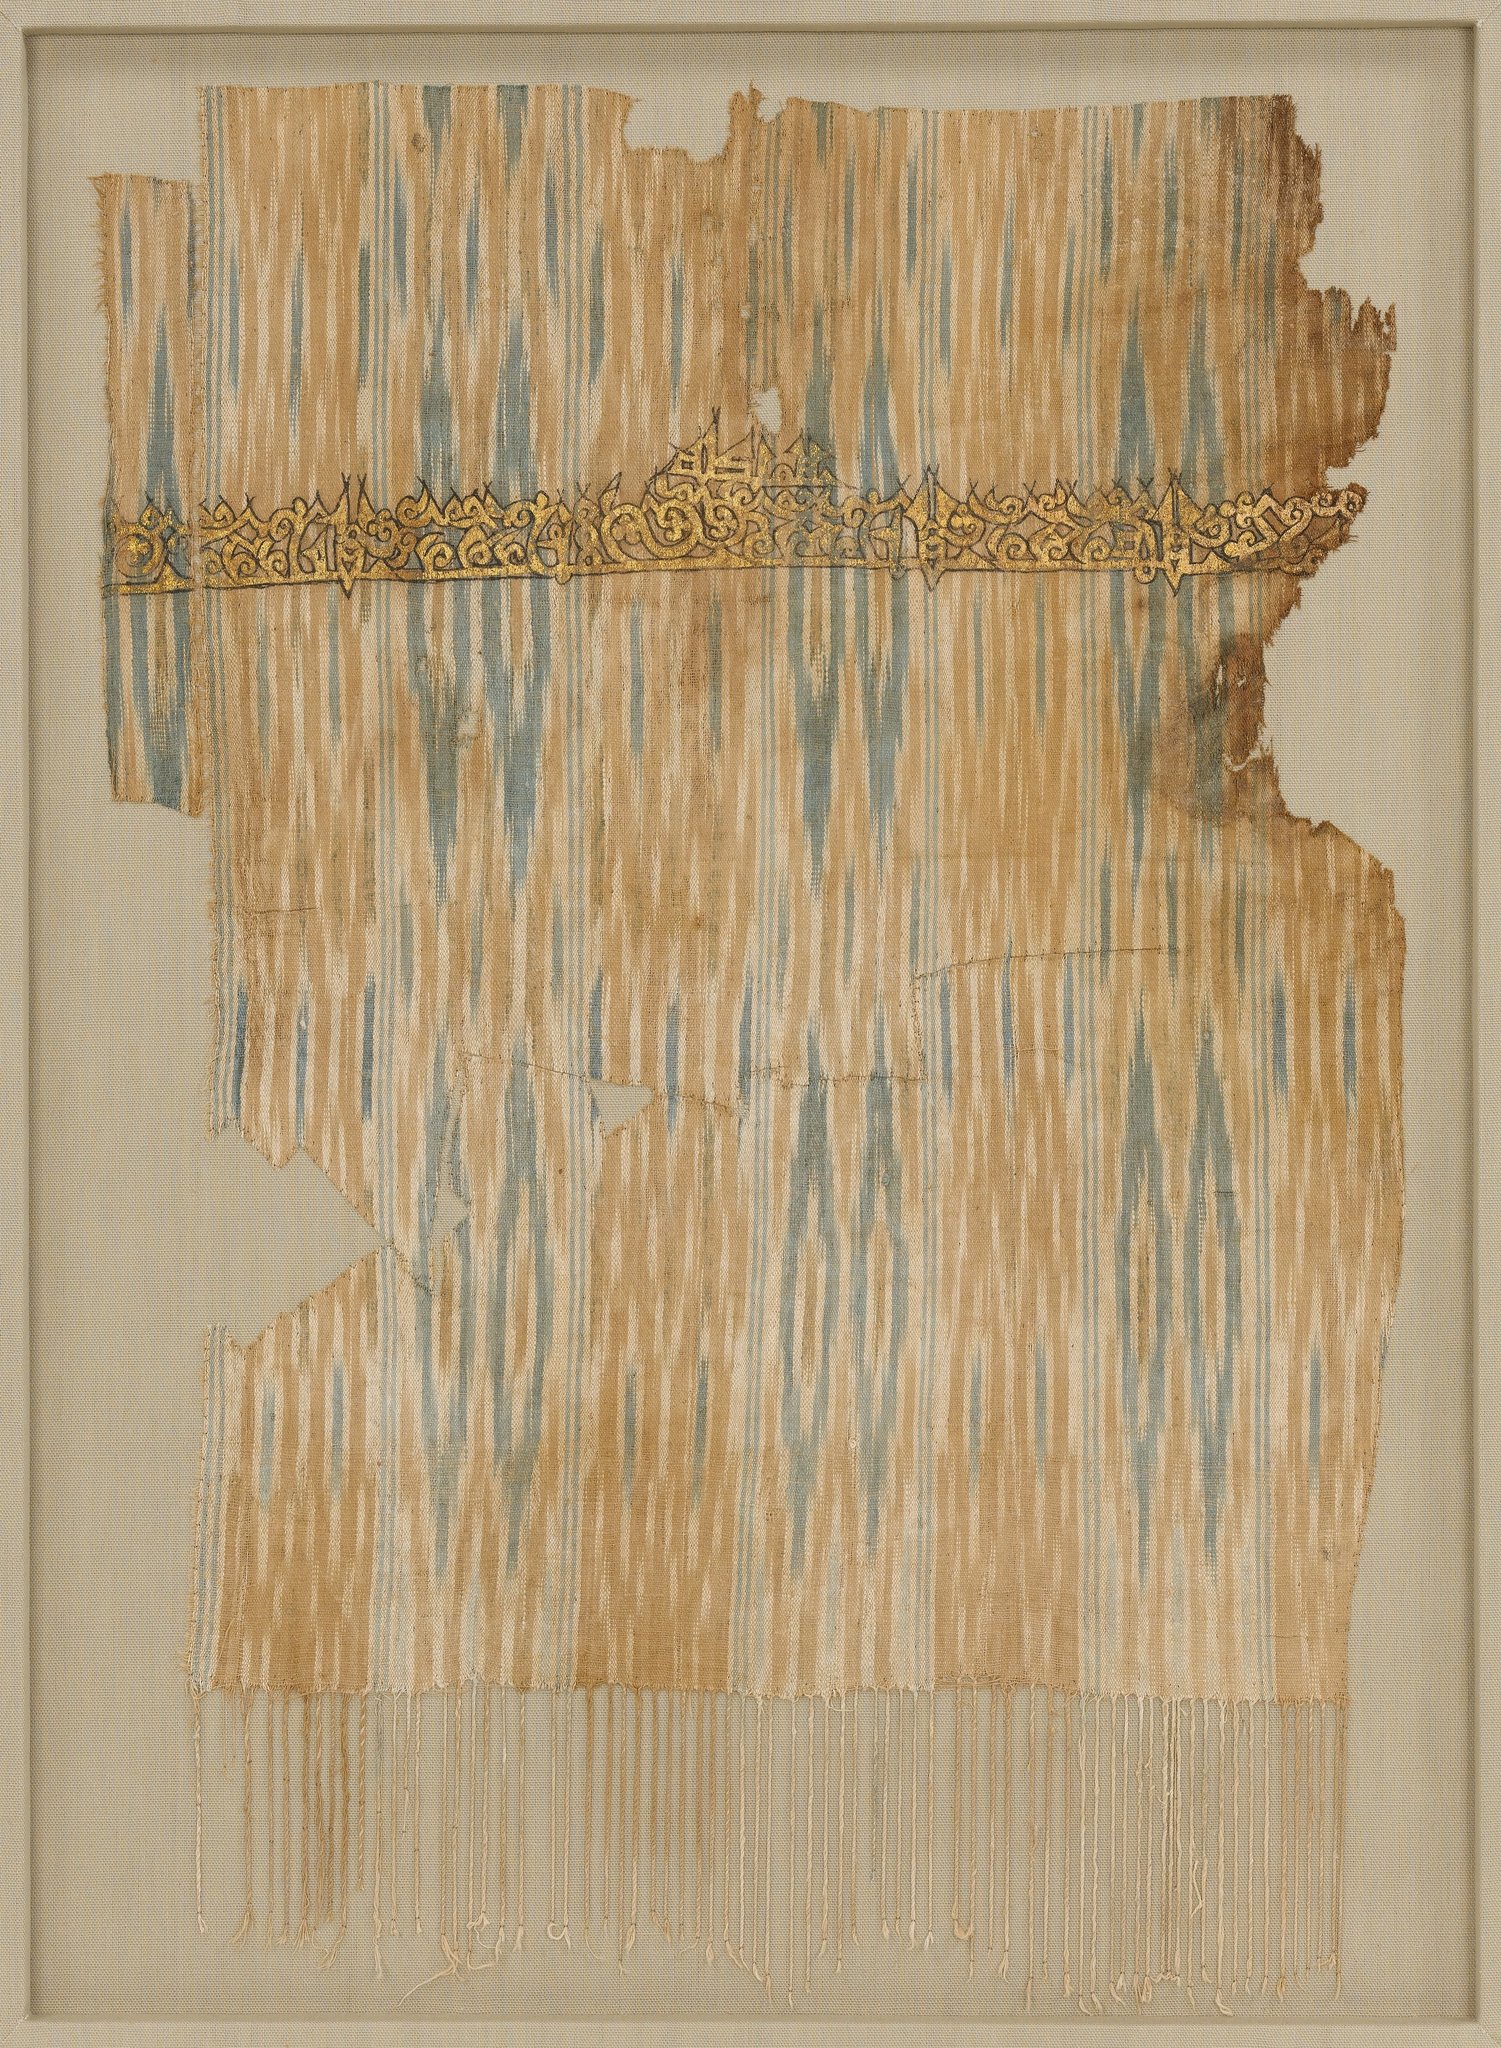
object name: tiraz fragment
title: Tiraz Textile Fragment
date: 867-933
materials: cotton, gold, gold leaf, ink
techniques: dyeing, painting, weave, resist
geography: yemen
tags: arabic